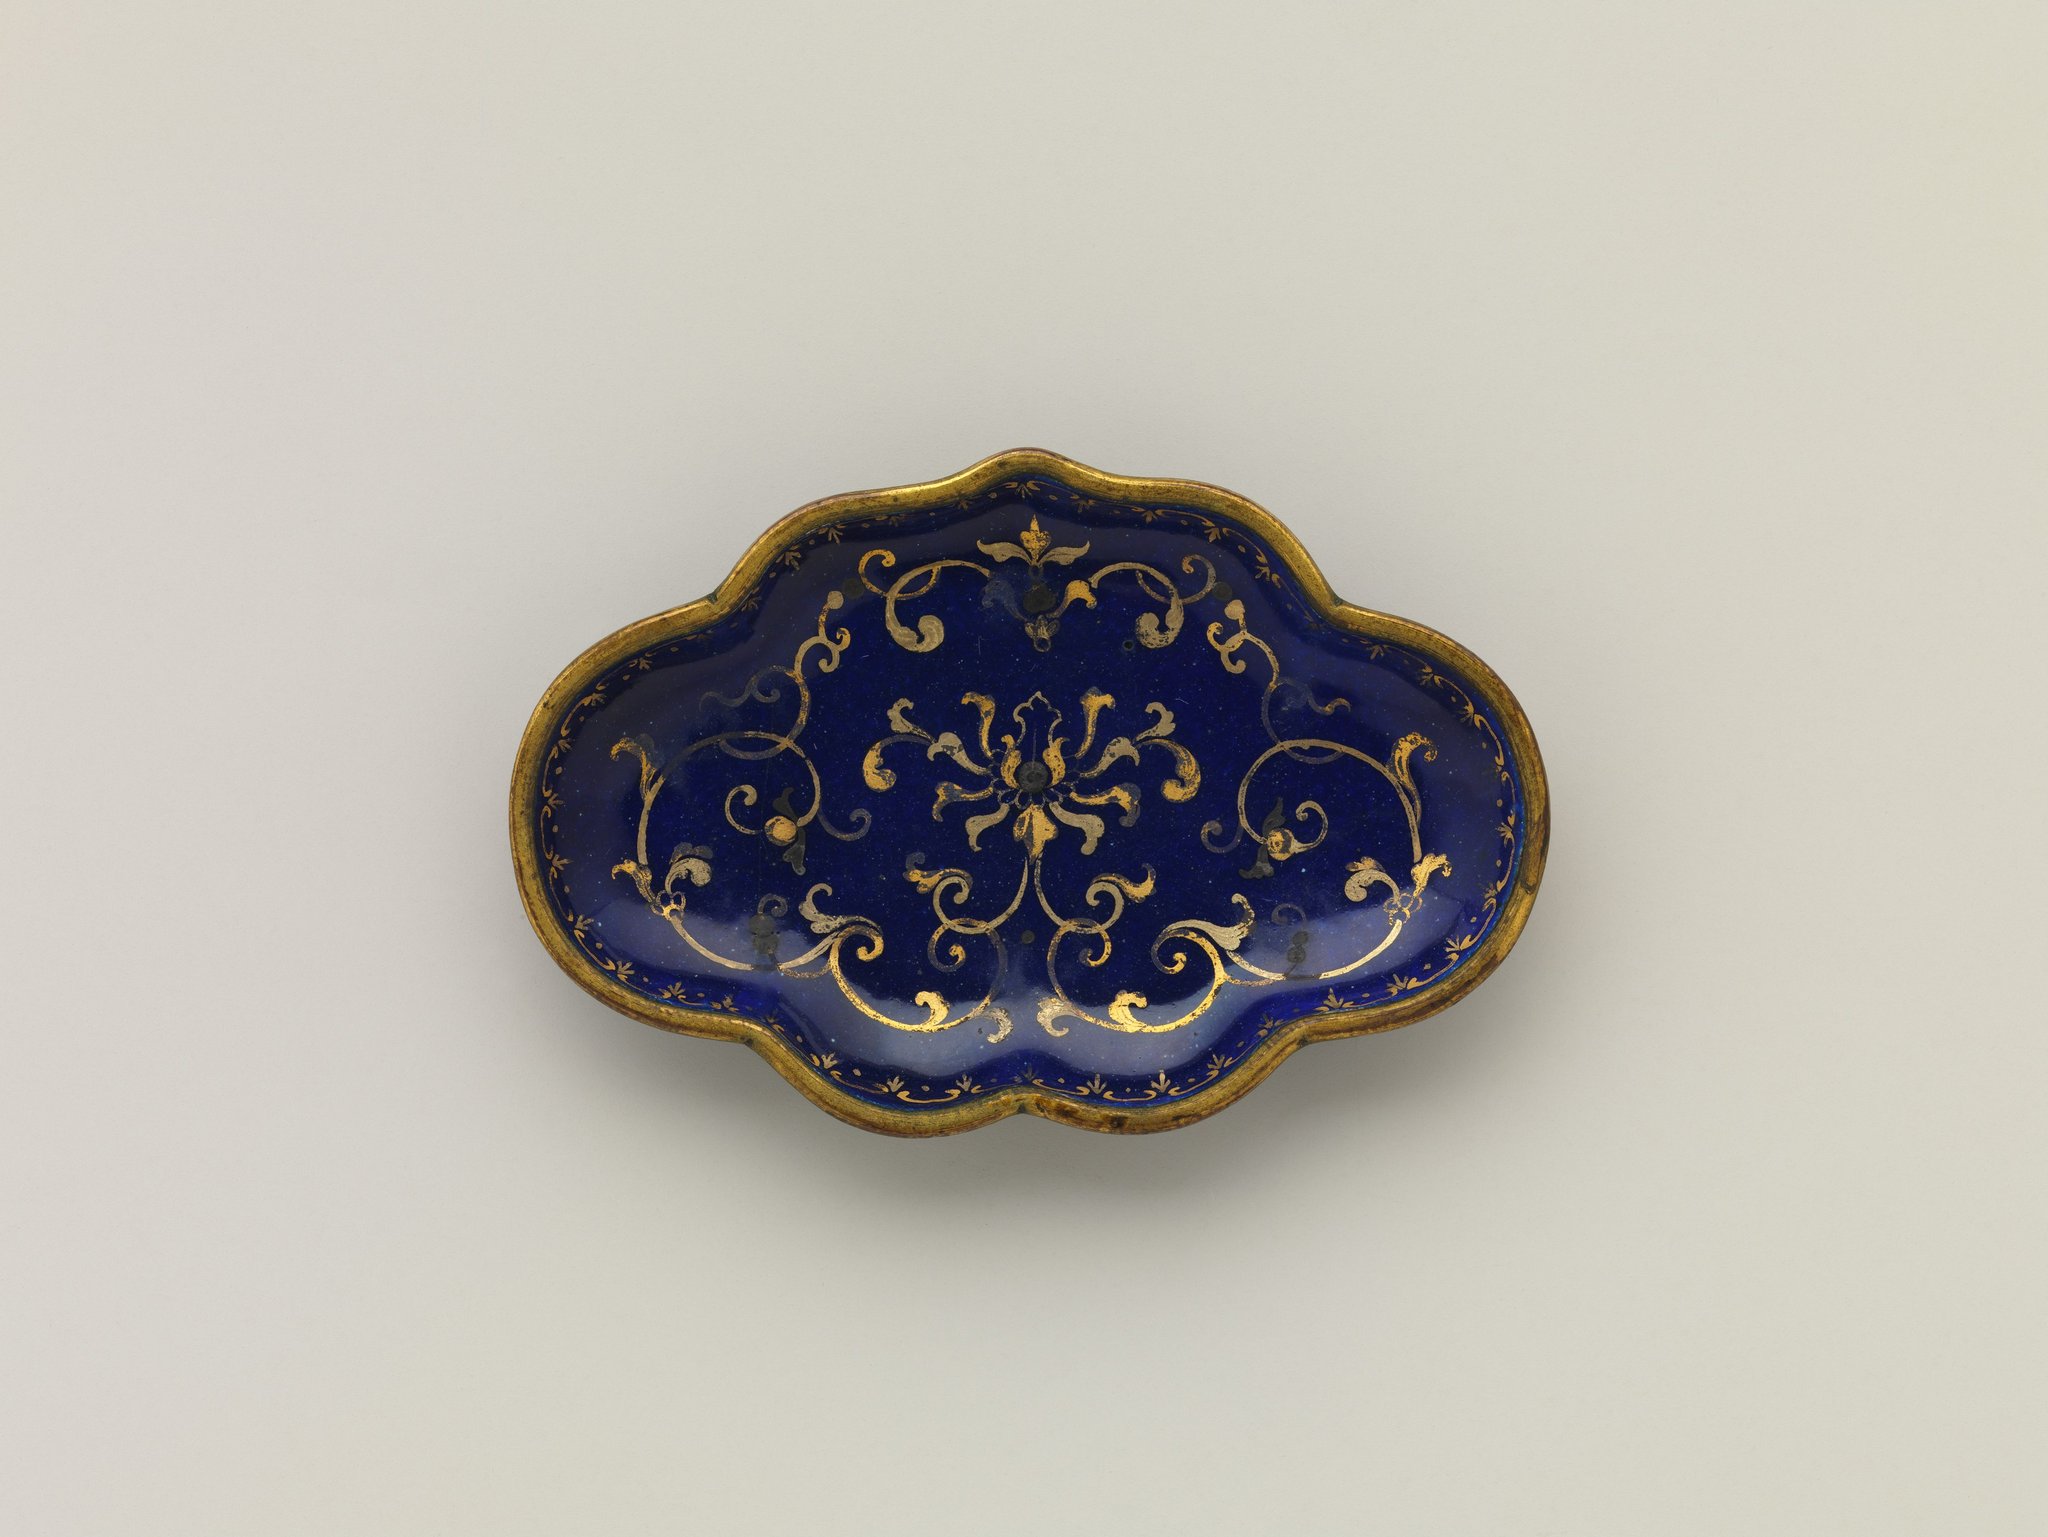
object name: tray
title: Tray in the Shape of a Flower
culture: chinese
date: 1701-1800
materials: copper, enamel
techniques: gilding, painting